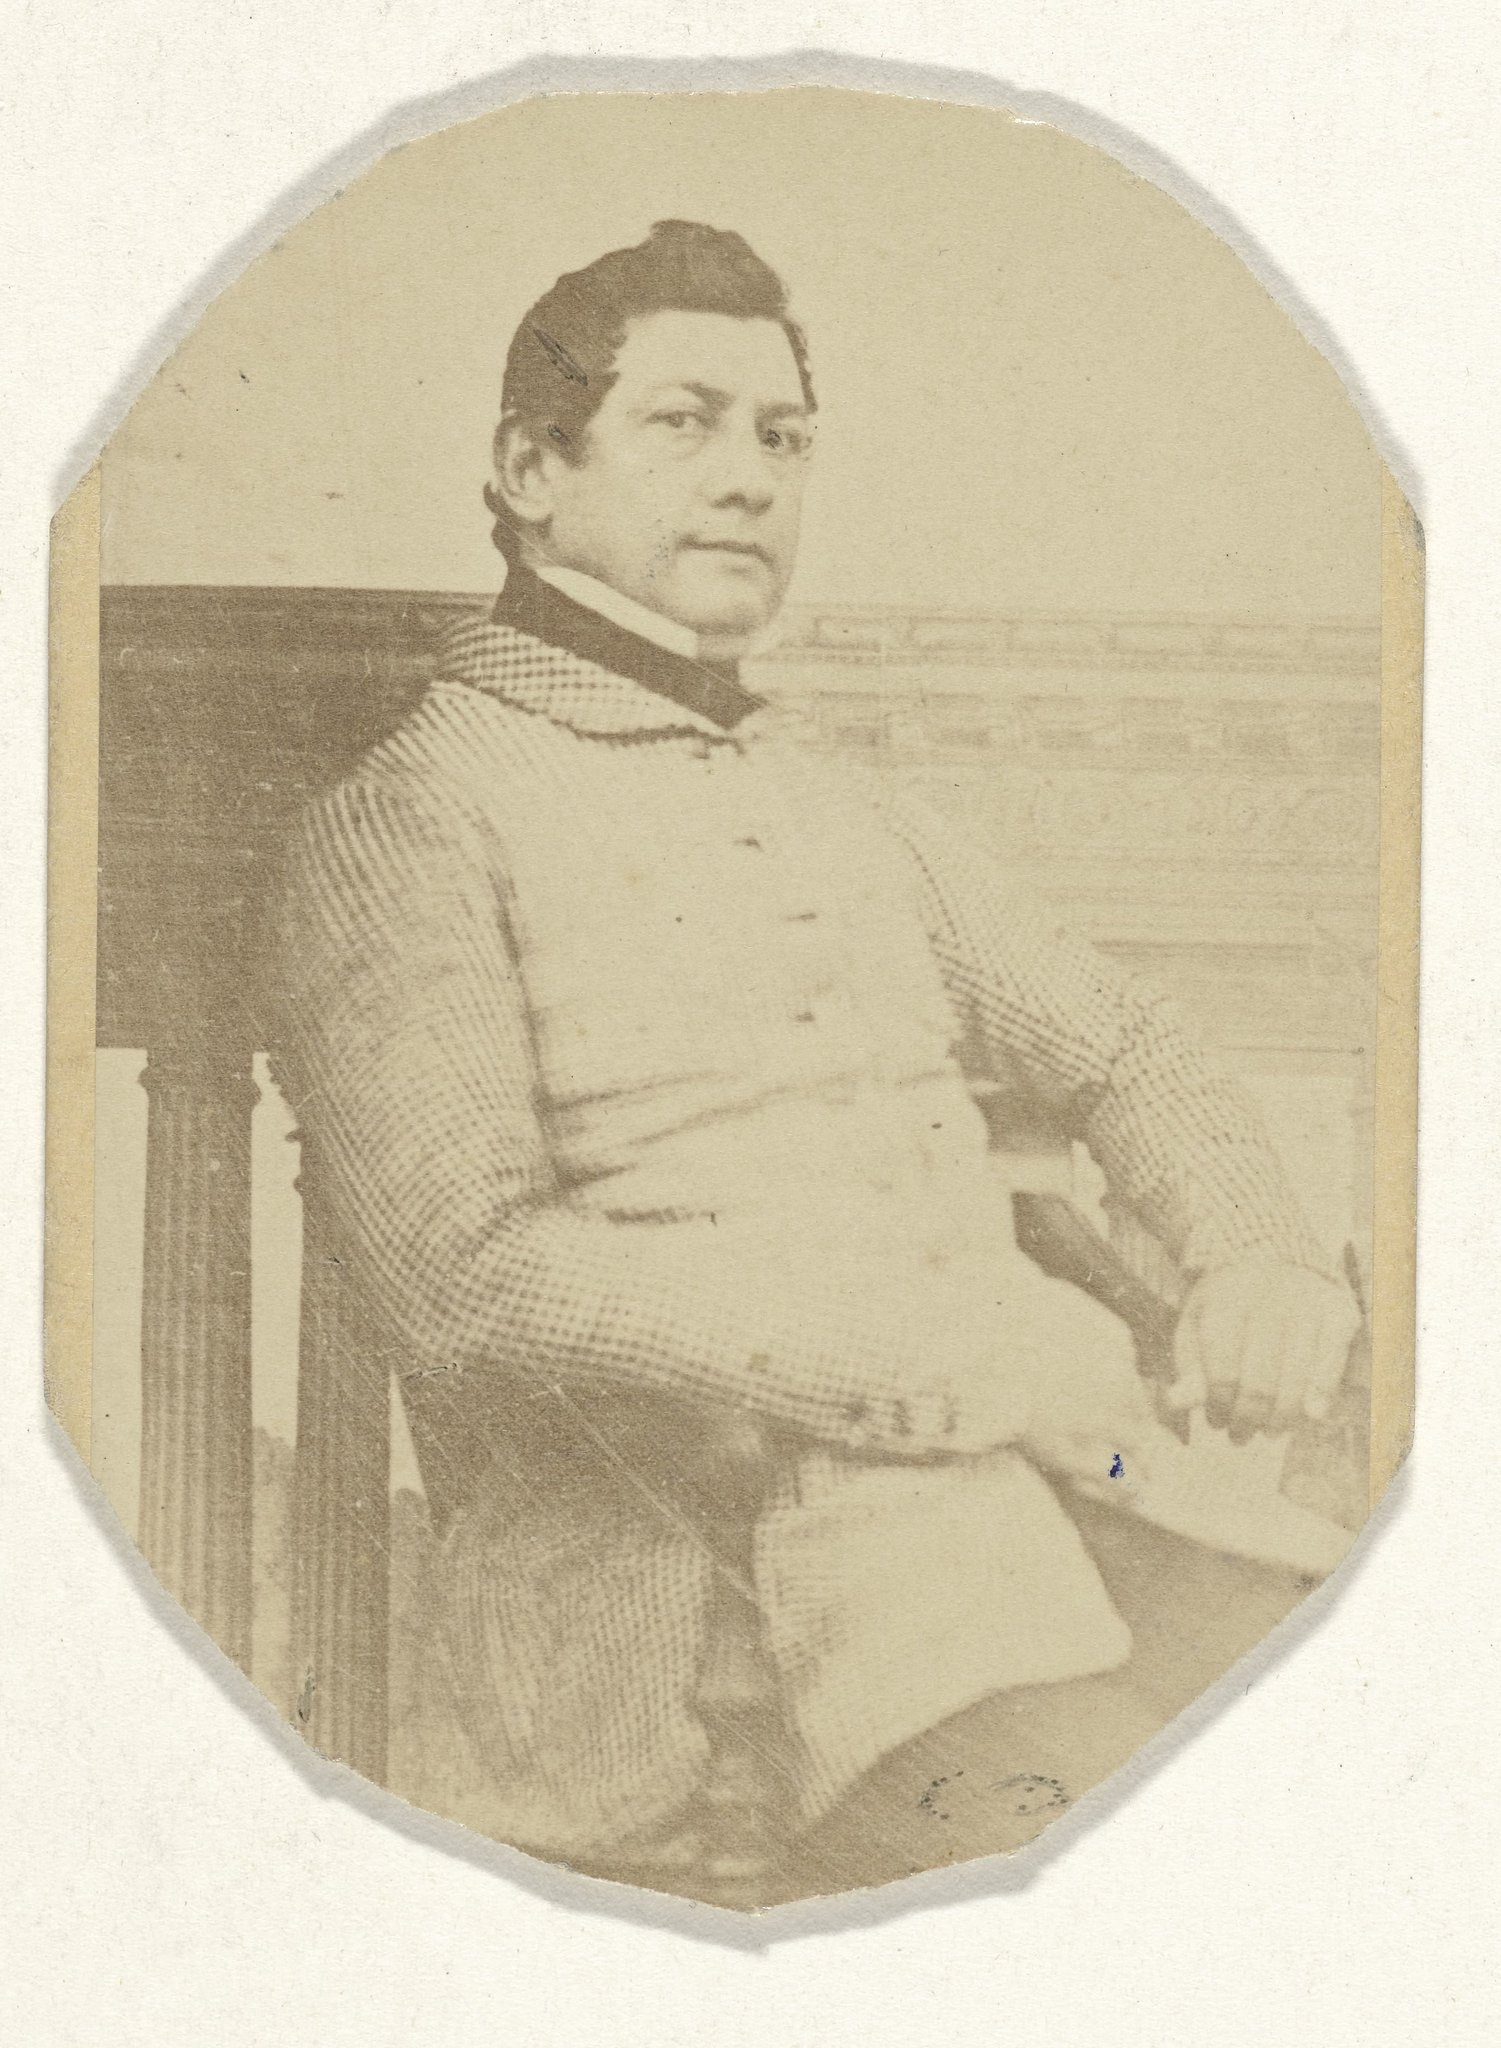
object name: carte de visite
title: Fotoreproductie van een daguerreotypie met een portret van Jan Jacob van Braam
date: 1855-1870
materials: cardboard, paper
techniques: albumen print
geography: java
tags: batavia, arnhem, jan jacob van braam, adult man, historical persons, java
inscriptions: inscription: ‘Van Braam/ (grootvader van/ Ma)’, inscription: ‘Woodbury & Page/ Photographers/ Java’